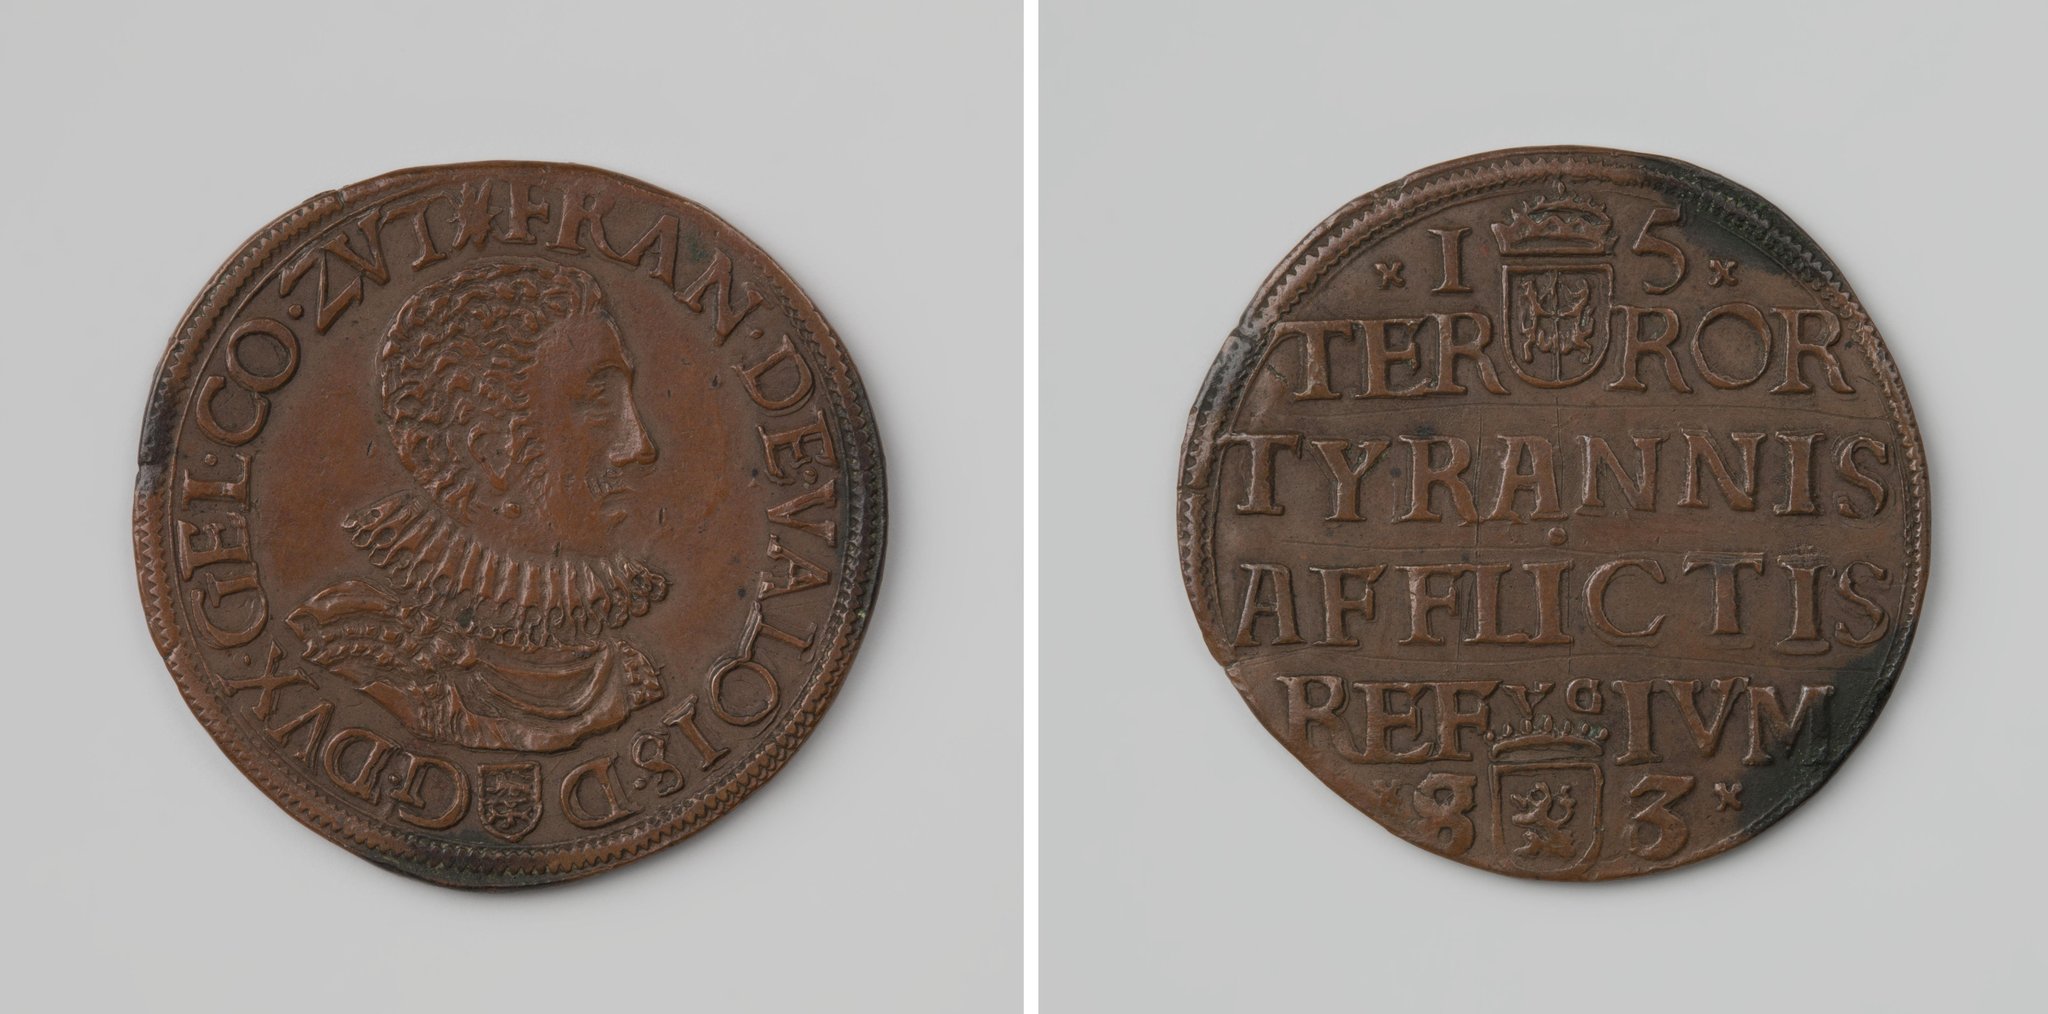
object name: jeton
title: Francois-Hercule, hertog van Anjou, rekenpenning van de Staten van Gelderland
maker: Anonymous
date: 1583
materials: copper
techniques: striking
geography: gelderland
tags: paris, françois-hercule de valois (hertog van anjou), gelderland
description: Koperen penning. Voorzijde: borststuk man binnen omschrift. Keerzijde: opschrift onder en boven gekroond wapenschild